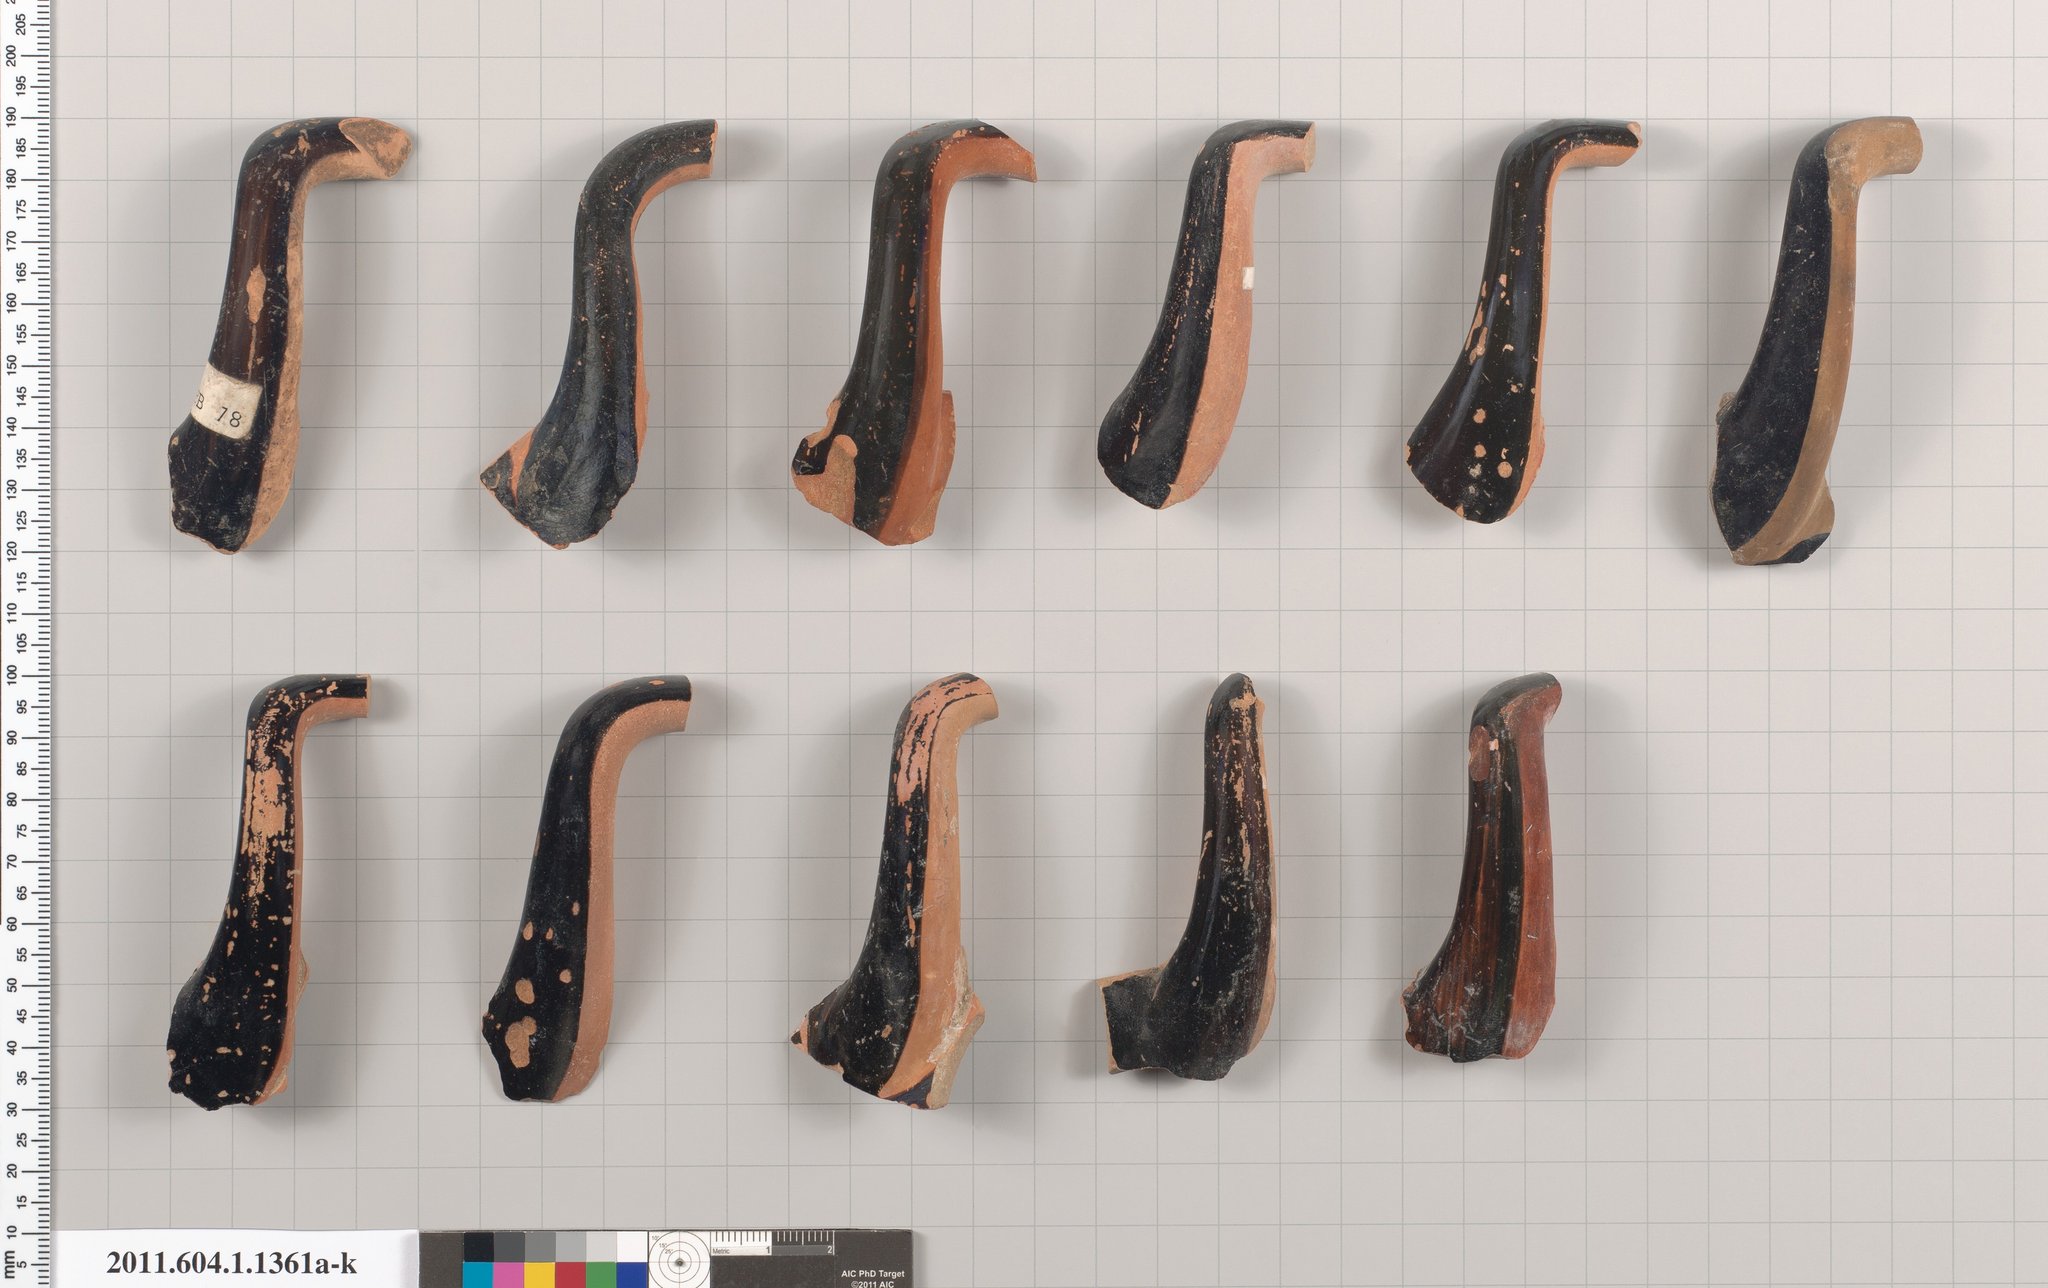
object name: kylix fragment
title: Terracotta fragments of kylikes (drinking cups)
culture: greek, attic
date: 500-401 BCE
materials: terracotta